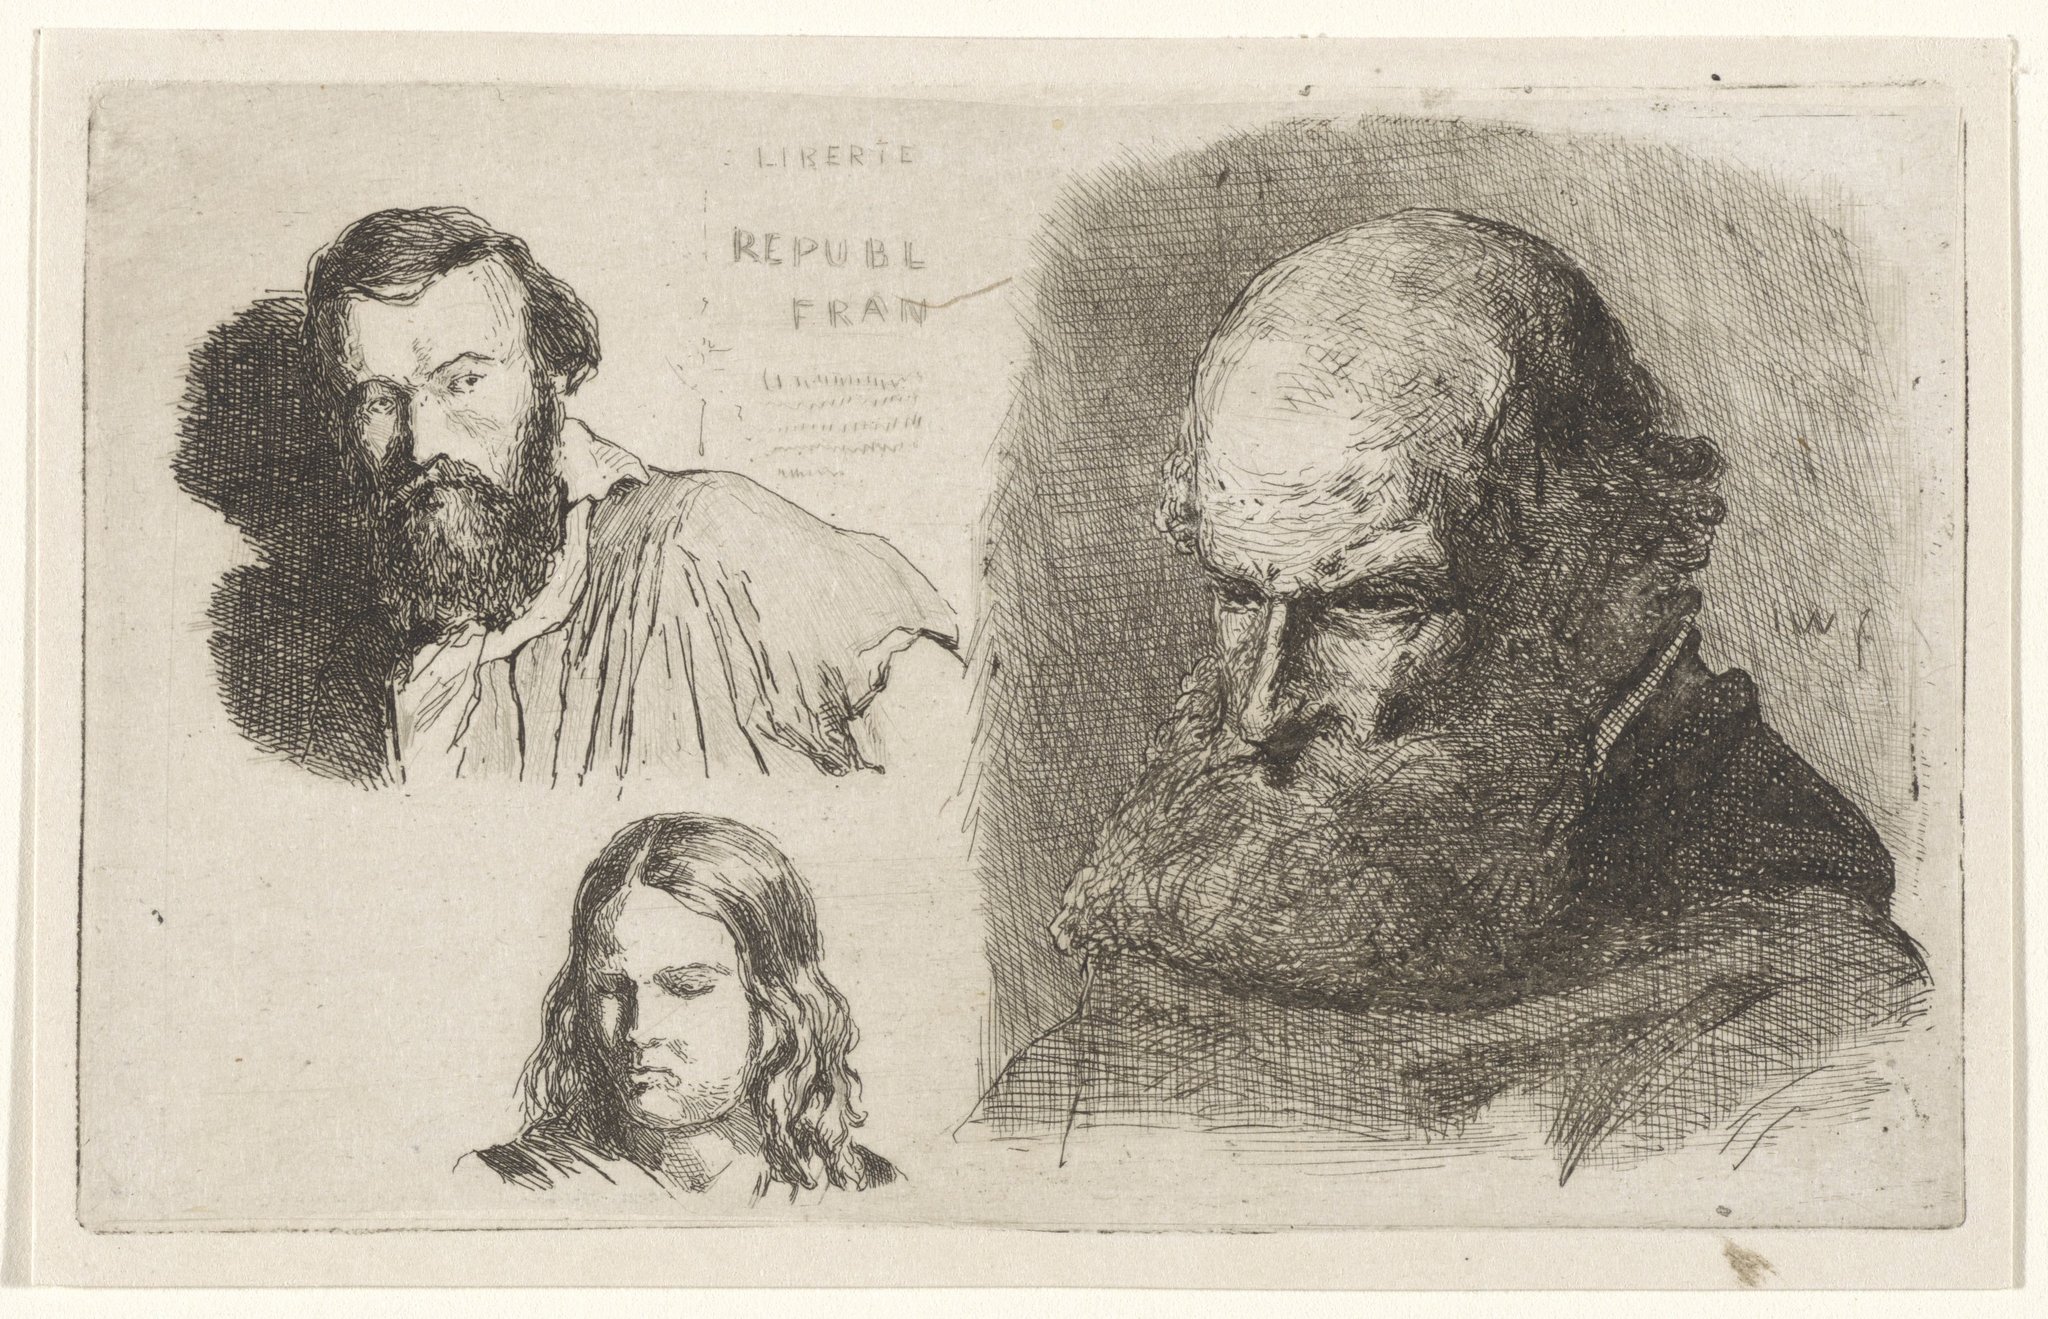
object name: print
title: Studie van een oude man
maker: jan weissenbruch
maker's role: painter, print maker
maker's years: 1822-1880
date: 1837-1880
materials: paper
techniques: etching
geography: the hague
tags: habit, frock, adult man, monk(s), friar(s), old man, beard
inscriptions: collector's mark: Lugt 2228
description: Drie voorstellingen op één plaat. Linksboven een studie van een man van middelbare leeftijd met een baard. Linksonder een studie van een jonge man en rechts een studie van een bebaarde oude man, mogelijk een monnik in een habijt. Midden boven staat de gedrukte Franstalige tekst 'Liberte Republ Fran'.